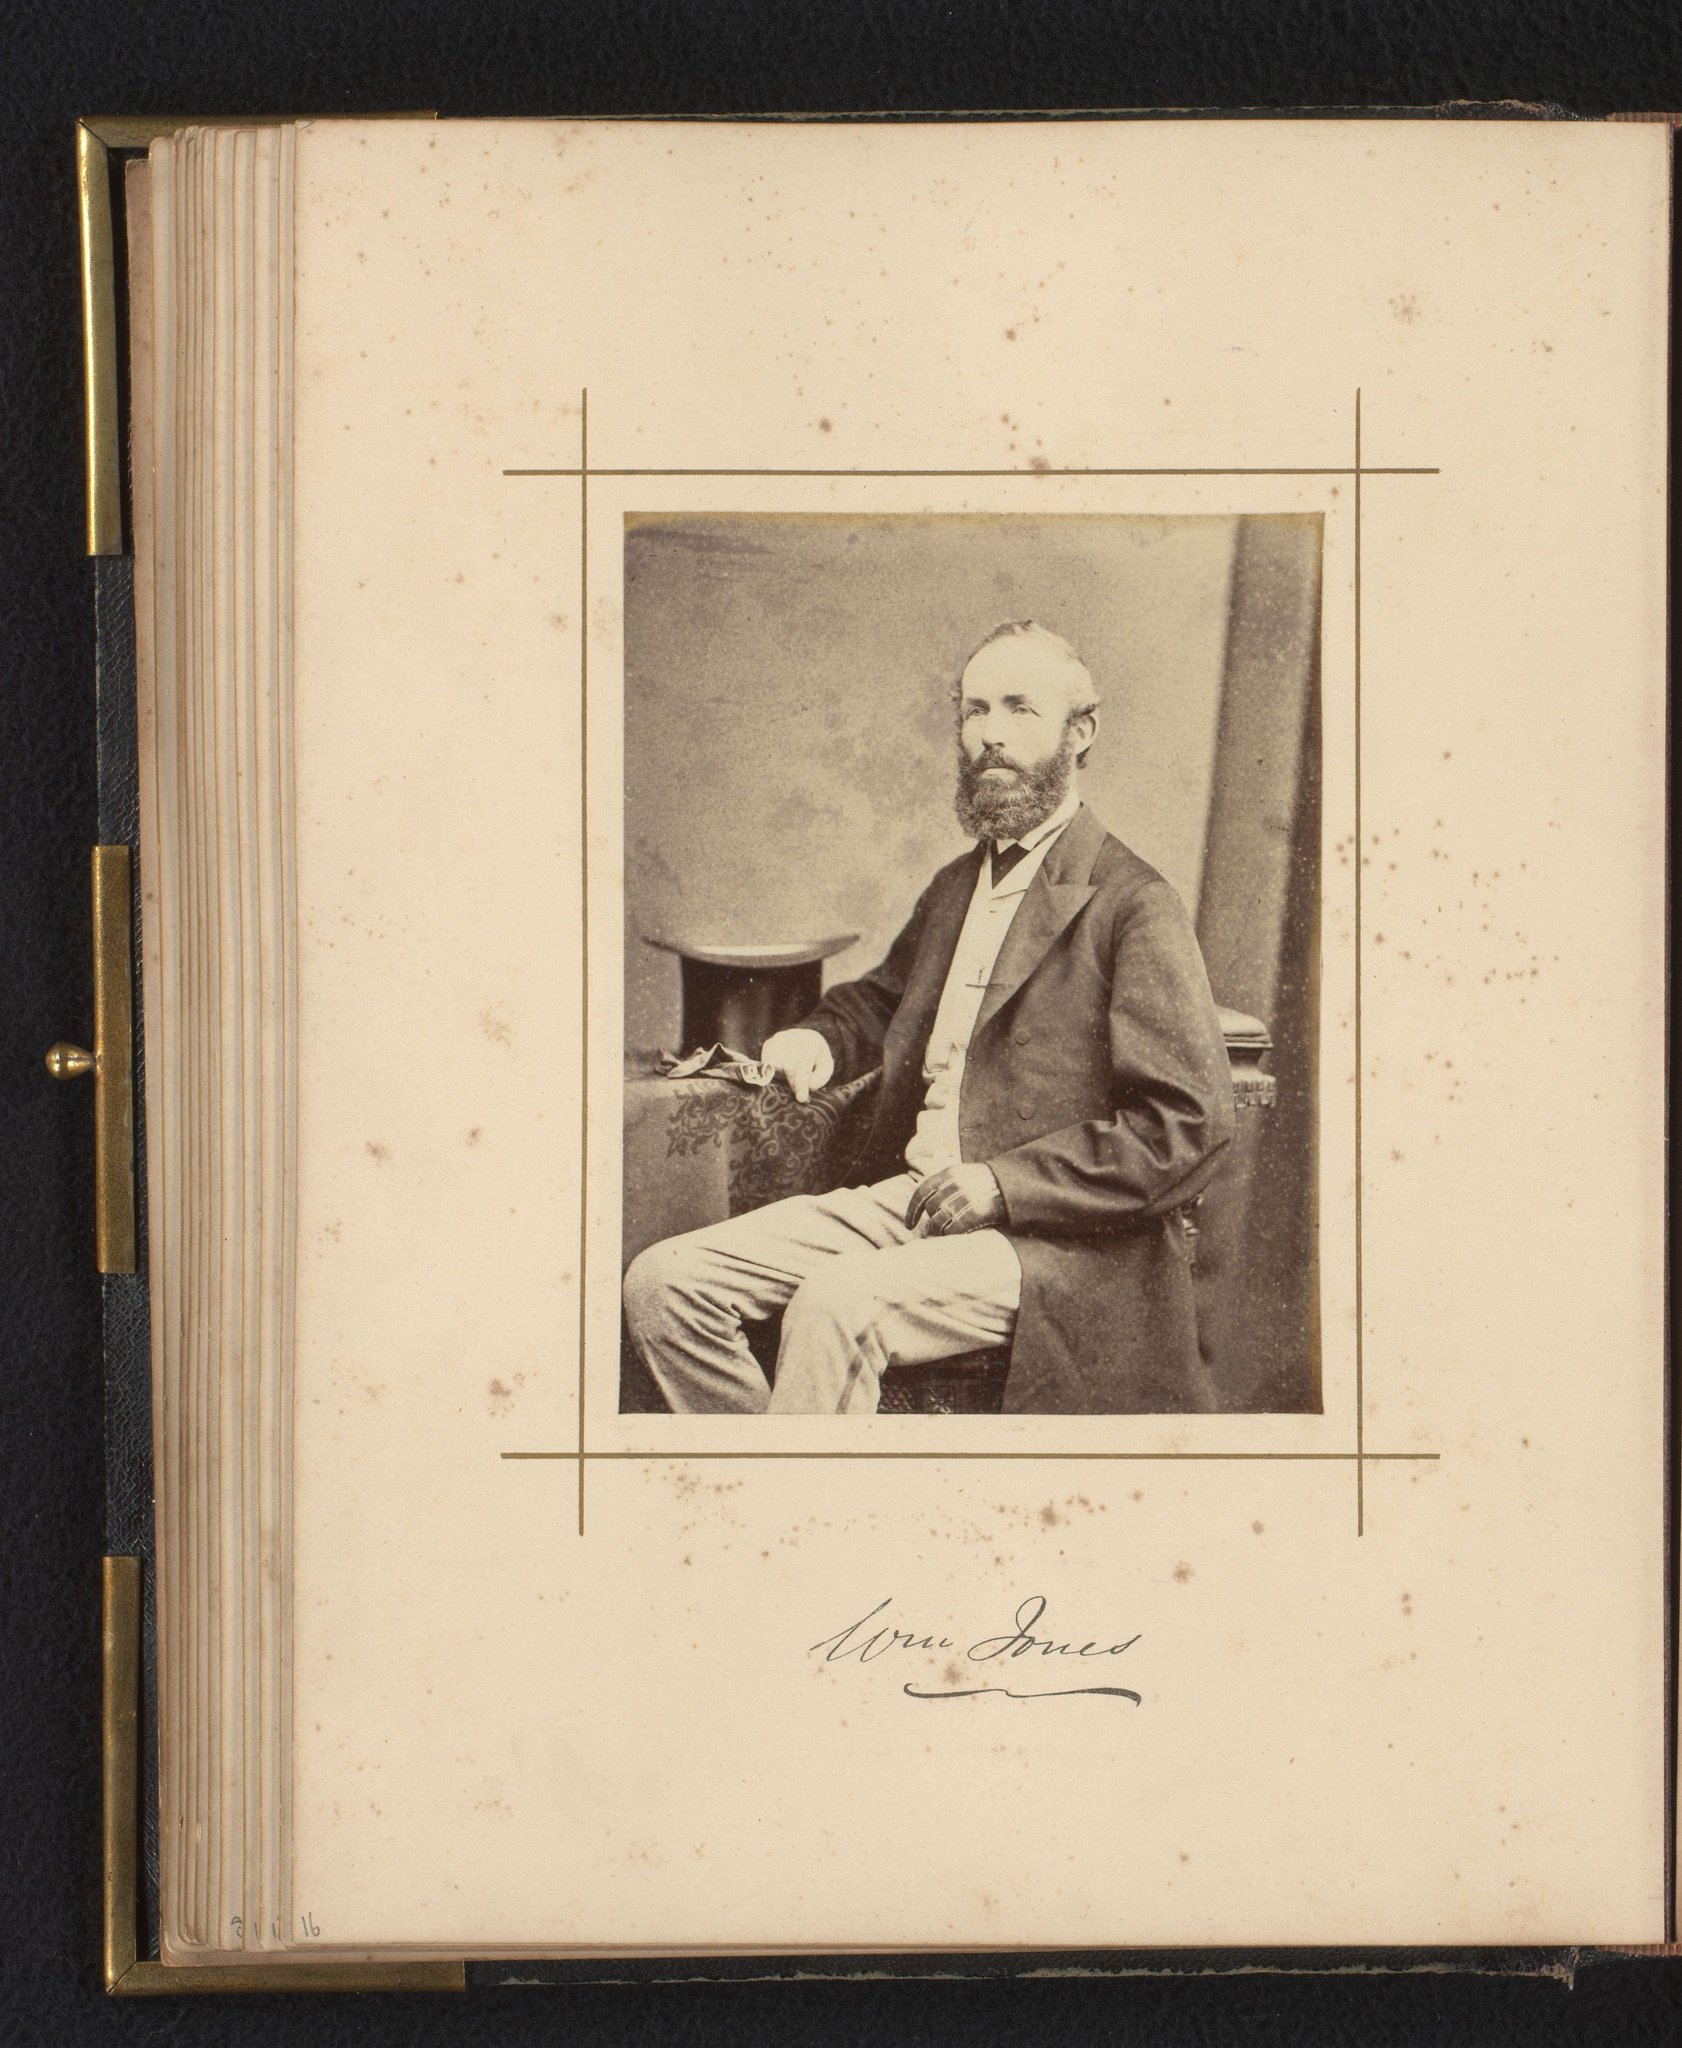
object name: photograph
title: Portret van een zittende man met hoge hoed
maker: Anonymous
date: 1866-1871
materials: photographic support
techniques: albumen print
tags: historical persons, head-gear: top hat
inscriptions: name: ‘[...] Jones’